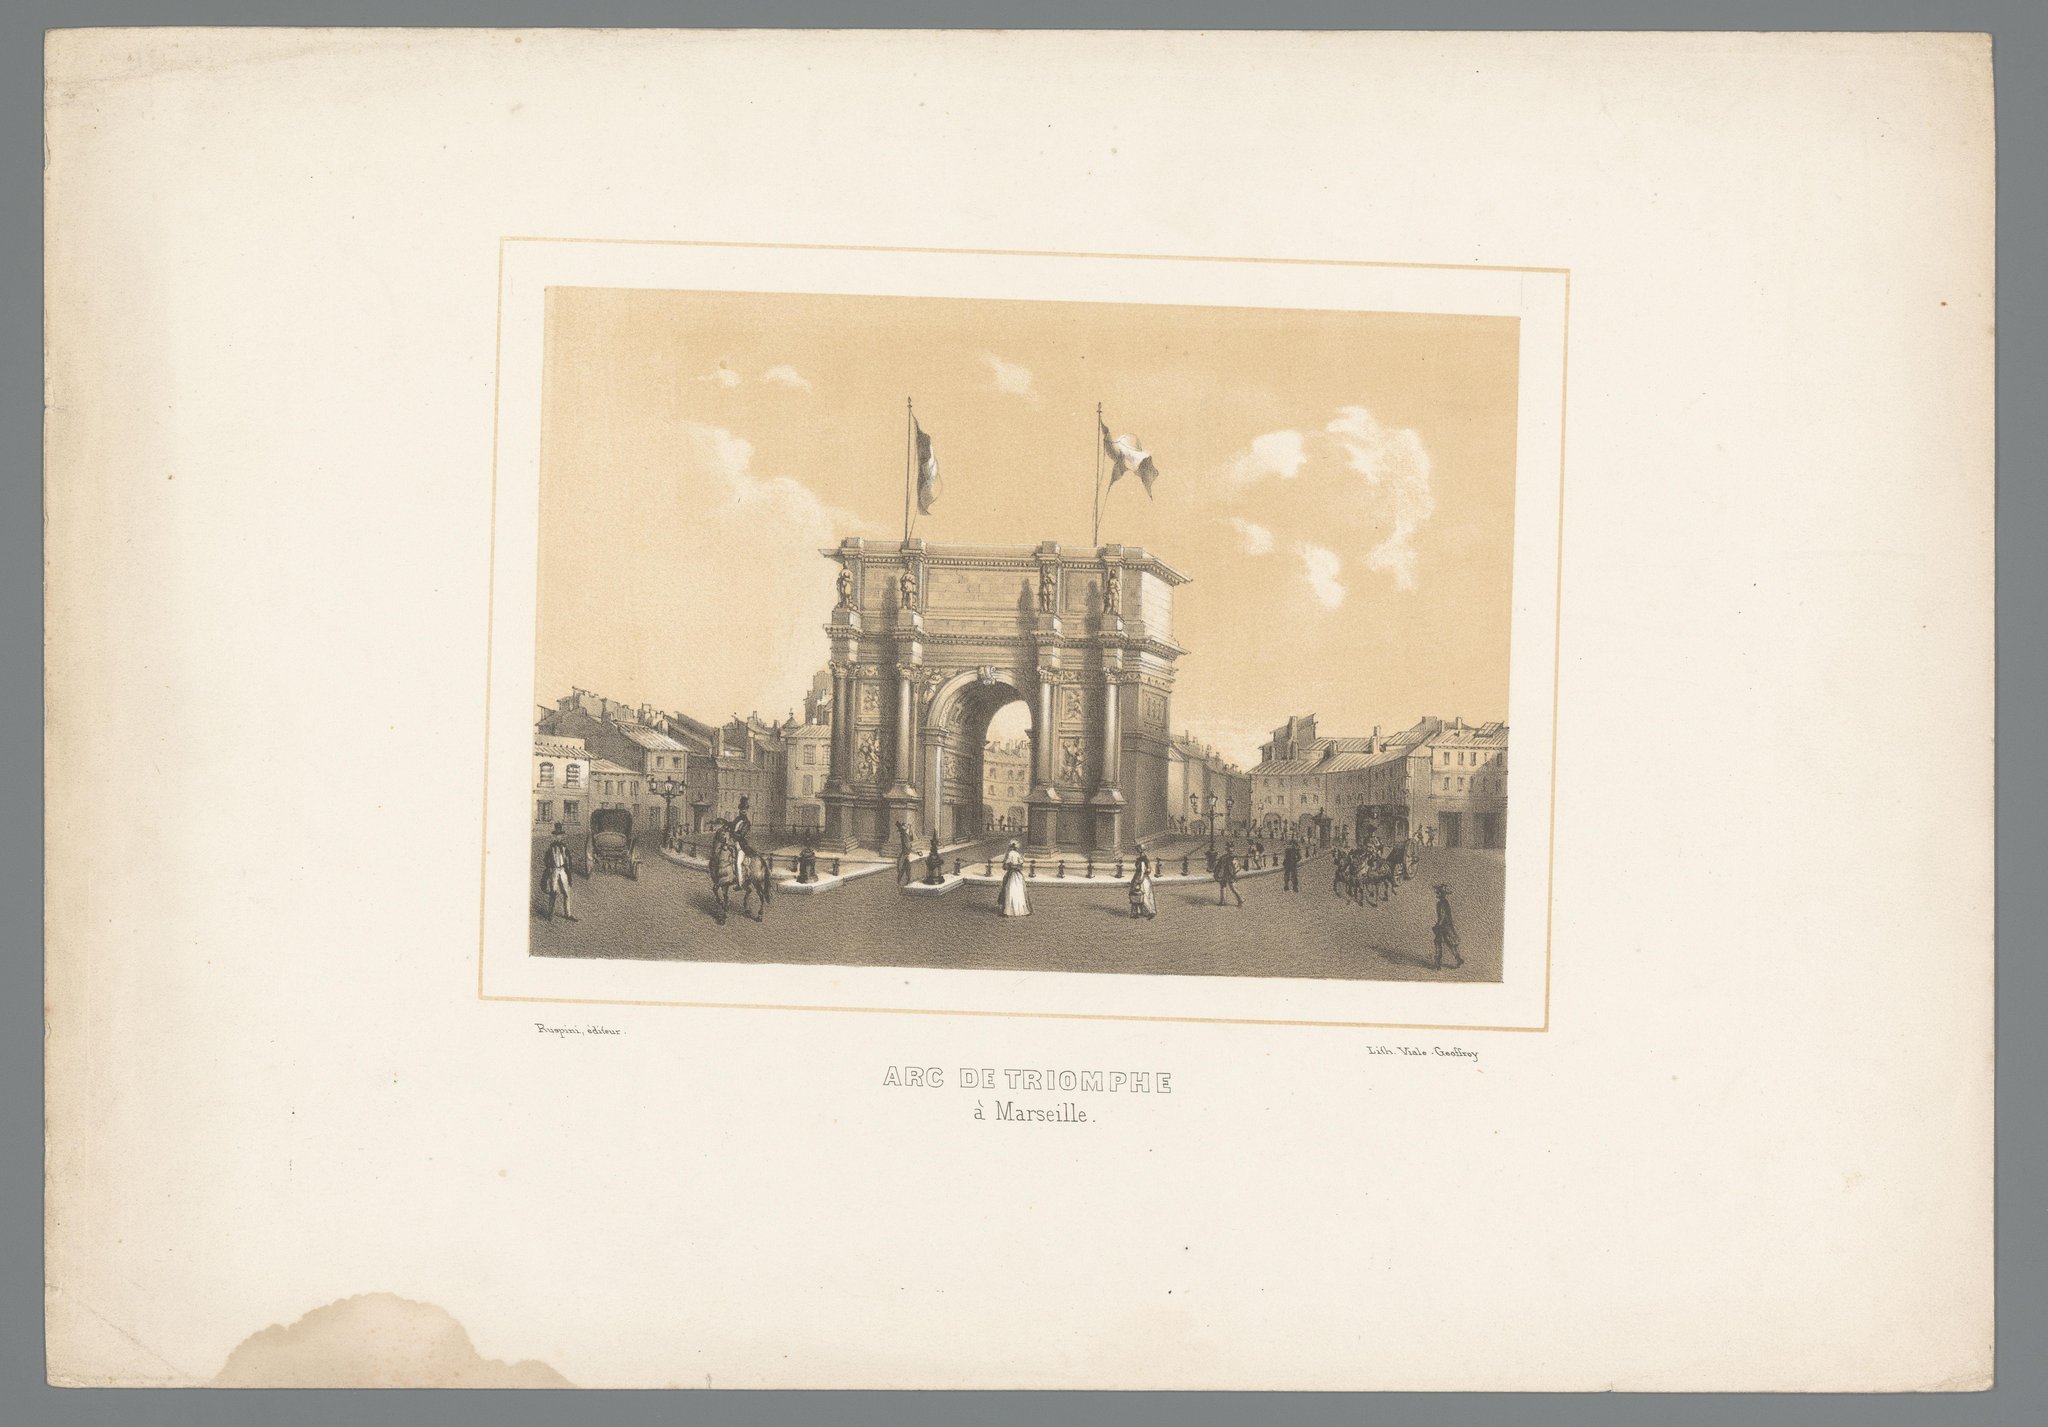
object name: print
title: Zicht op de Porte d'Aix in Marseille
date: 1842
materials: paper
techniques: tone lithography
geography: marseille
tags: triumphal arch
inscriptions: collector's mark: Lugt 2228